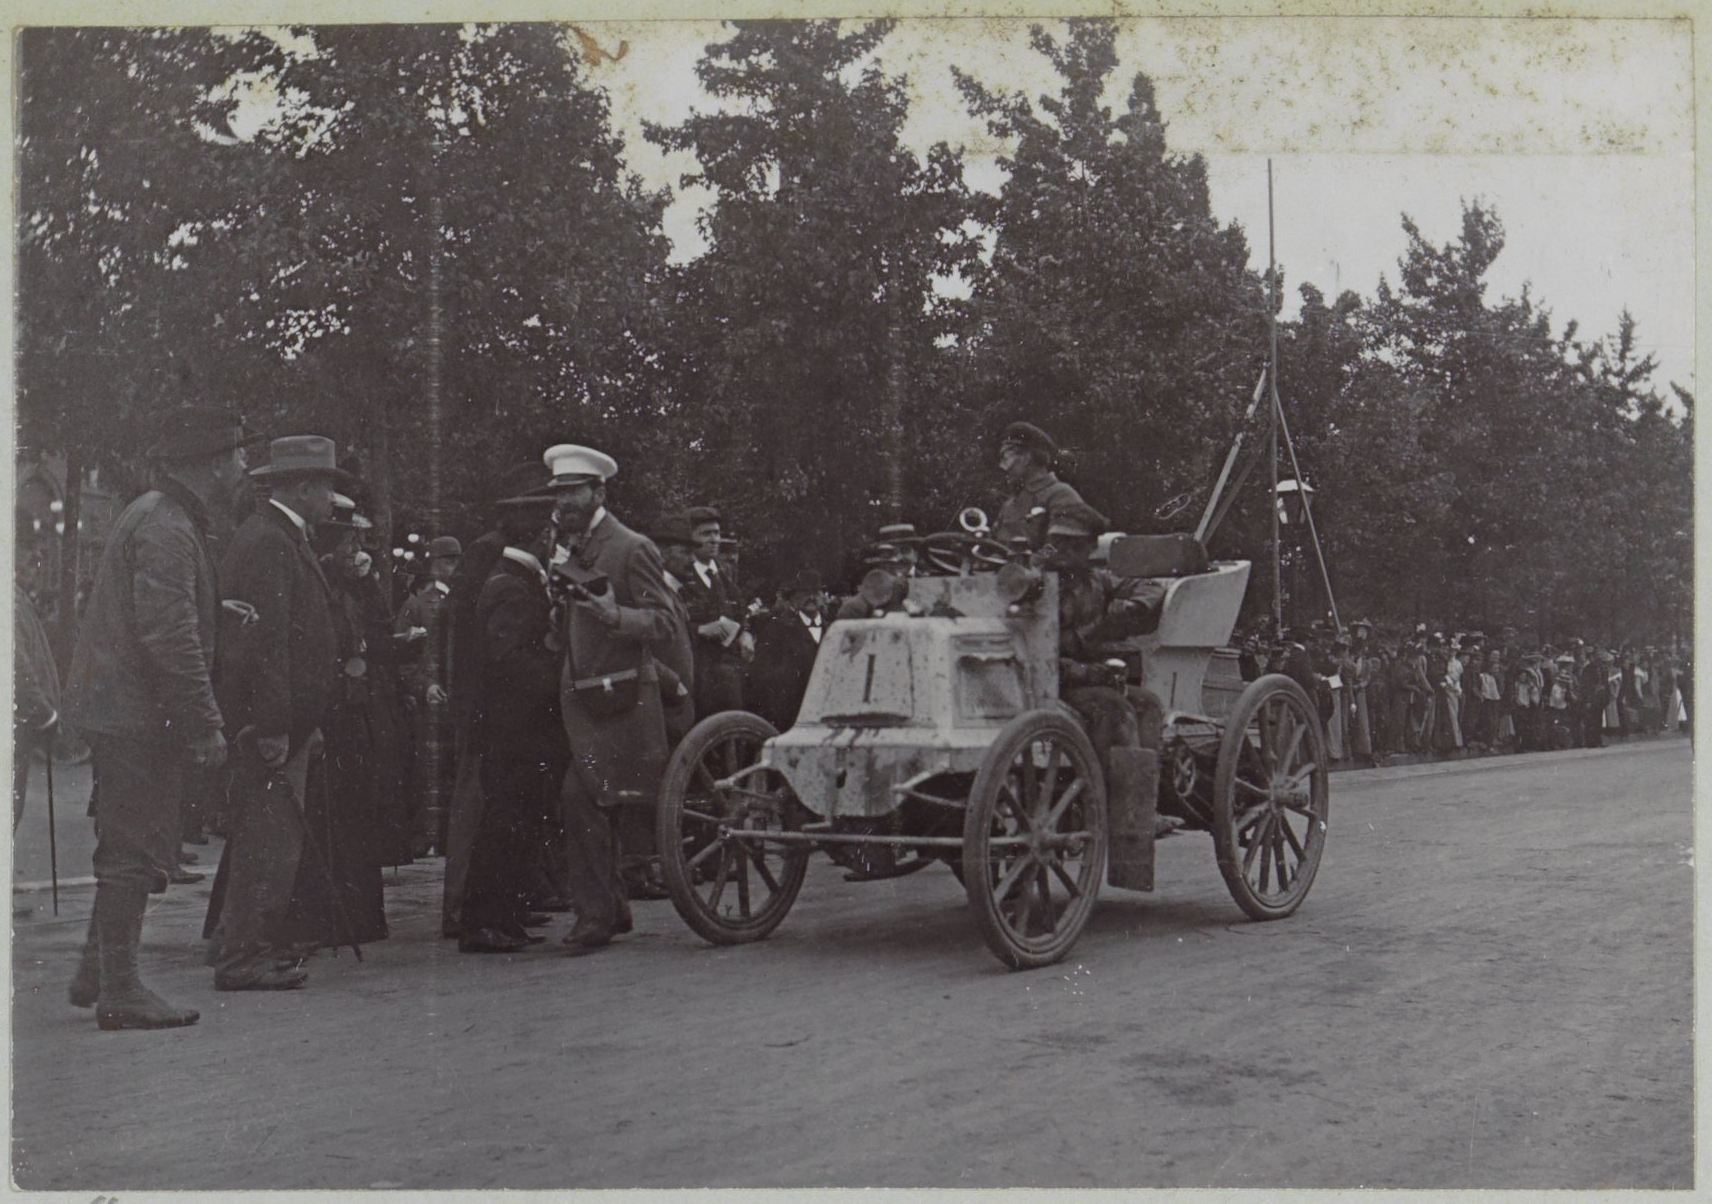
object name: photograph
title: Fernand Charron, één van de deelnemers aan (en latere winnaar van) de race Parijs-Amsterdam, in zijn automobiel onderweg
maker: delizy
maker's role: manufacturer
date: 1807-1898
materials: paper, photographic support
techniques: collodion silver print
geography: western europe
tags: motorcar racing, automobile, street (+ city(-scape) with figures, staffage)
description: Onderdeel van Fotoalbum van een Franse amateurfotograaf met opnames van uitstapjes in Frankrijk, Spanje, België, Luxemburg en Nederland, de eerste automobielen en autoraces.